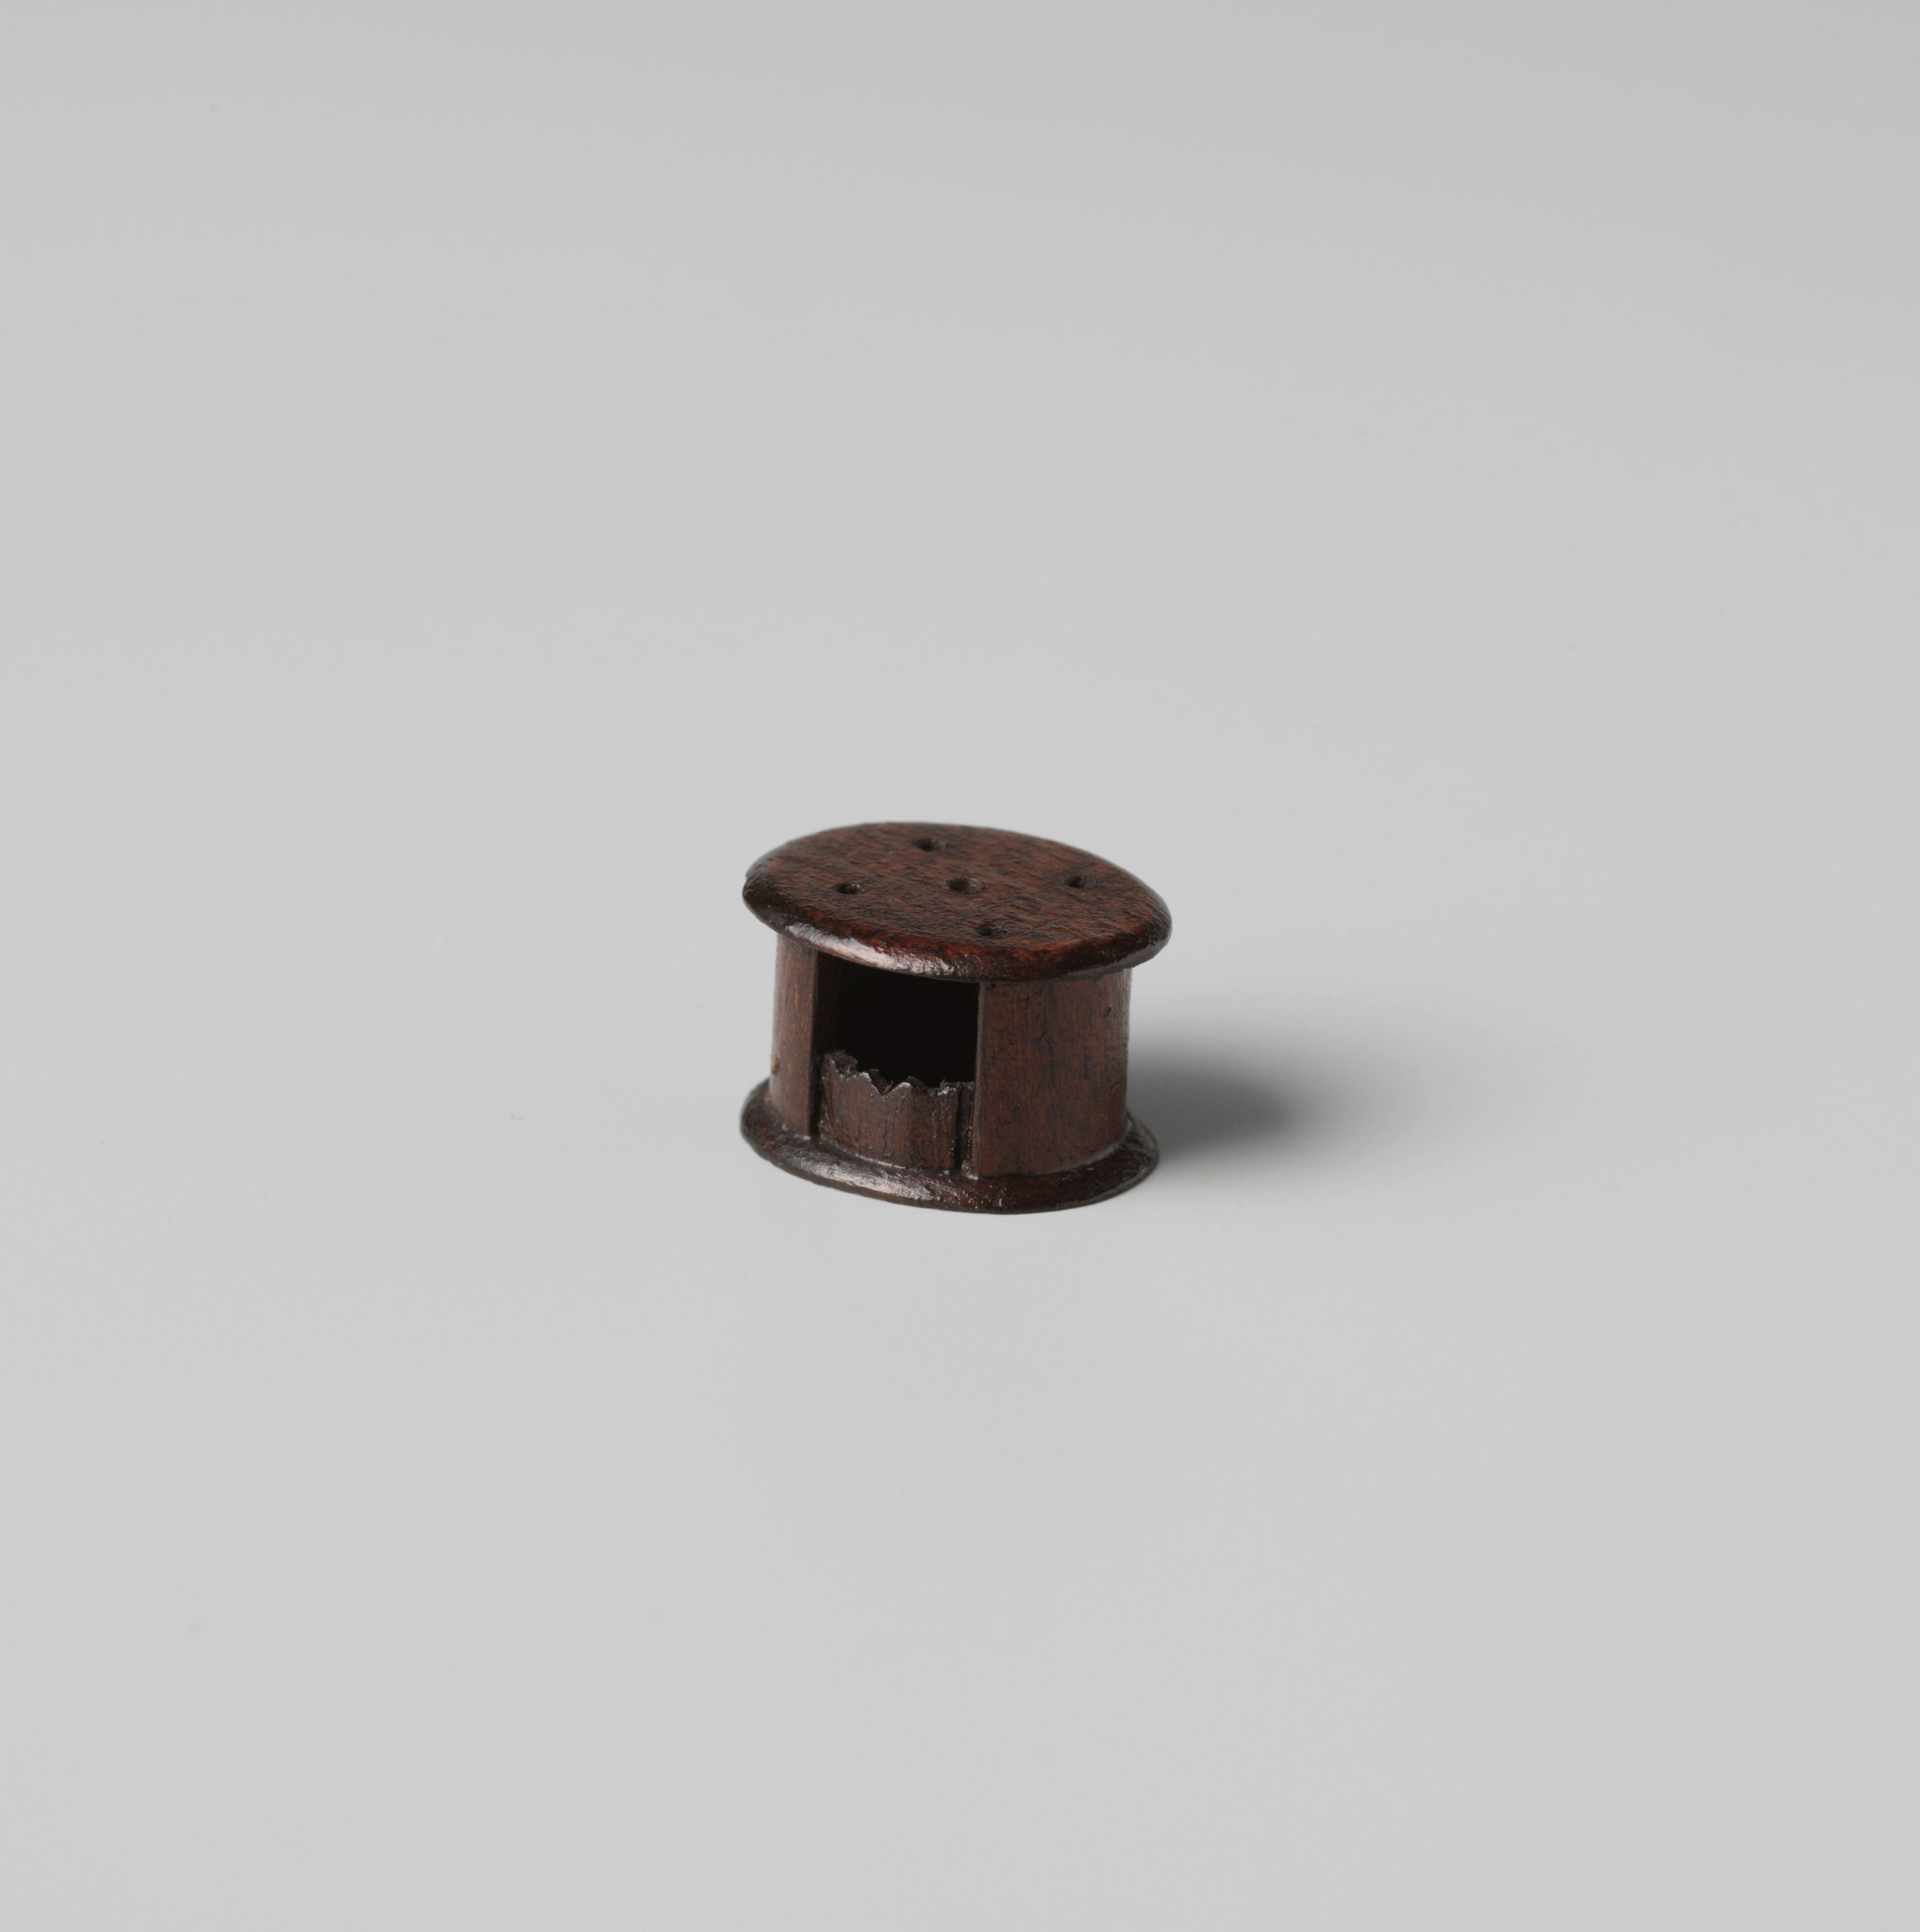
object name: furniture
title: Stoof, ovaal, met vijf gaten in de bovenzijde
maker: Anonymous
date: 1740-1760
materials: wood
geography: amsterdam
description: Stoof van mahoniehout, ovaal met in de bovenzijde vijf gaten, de opening voor de vuurtest is afgewerkt met een geschulpte voorregel.